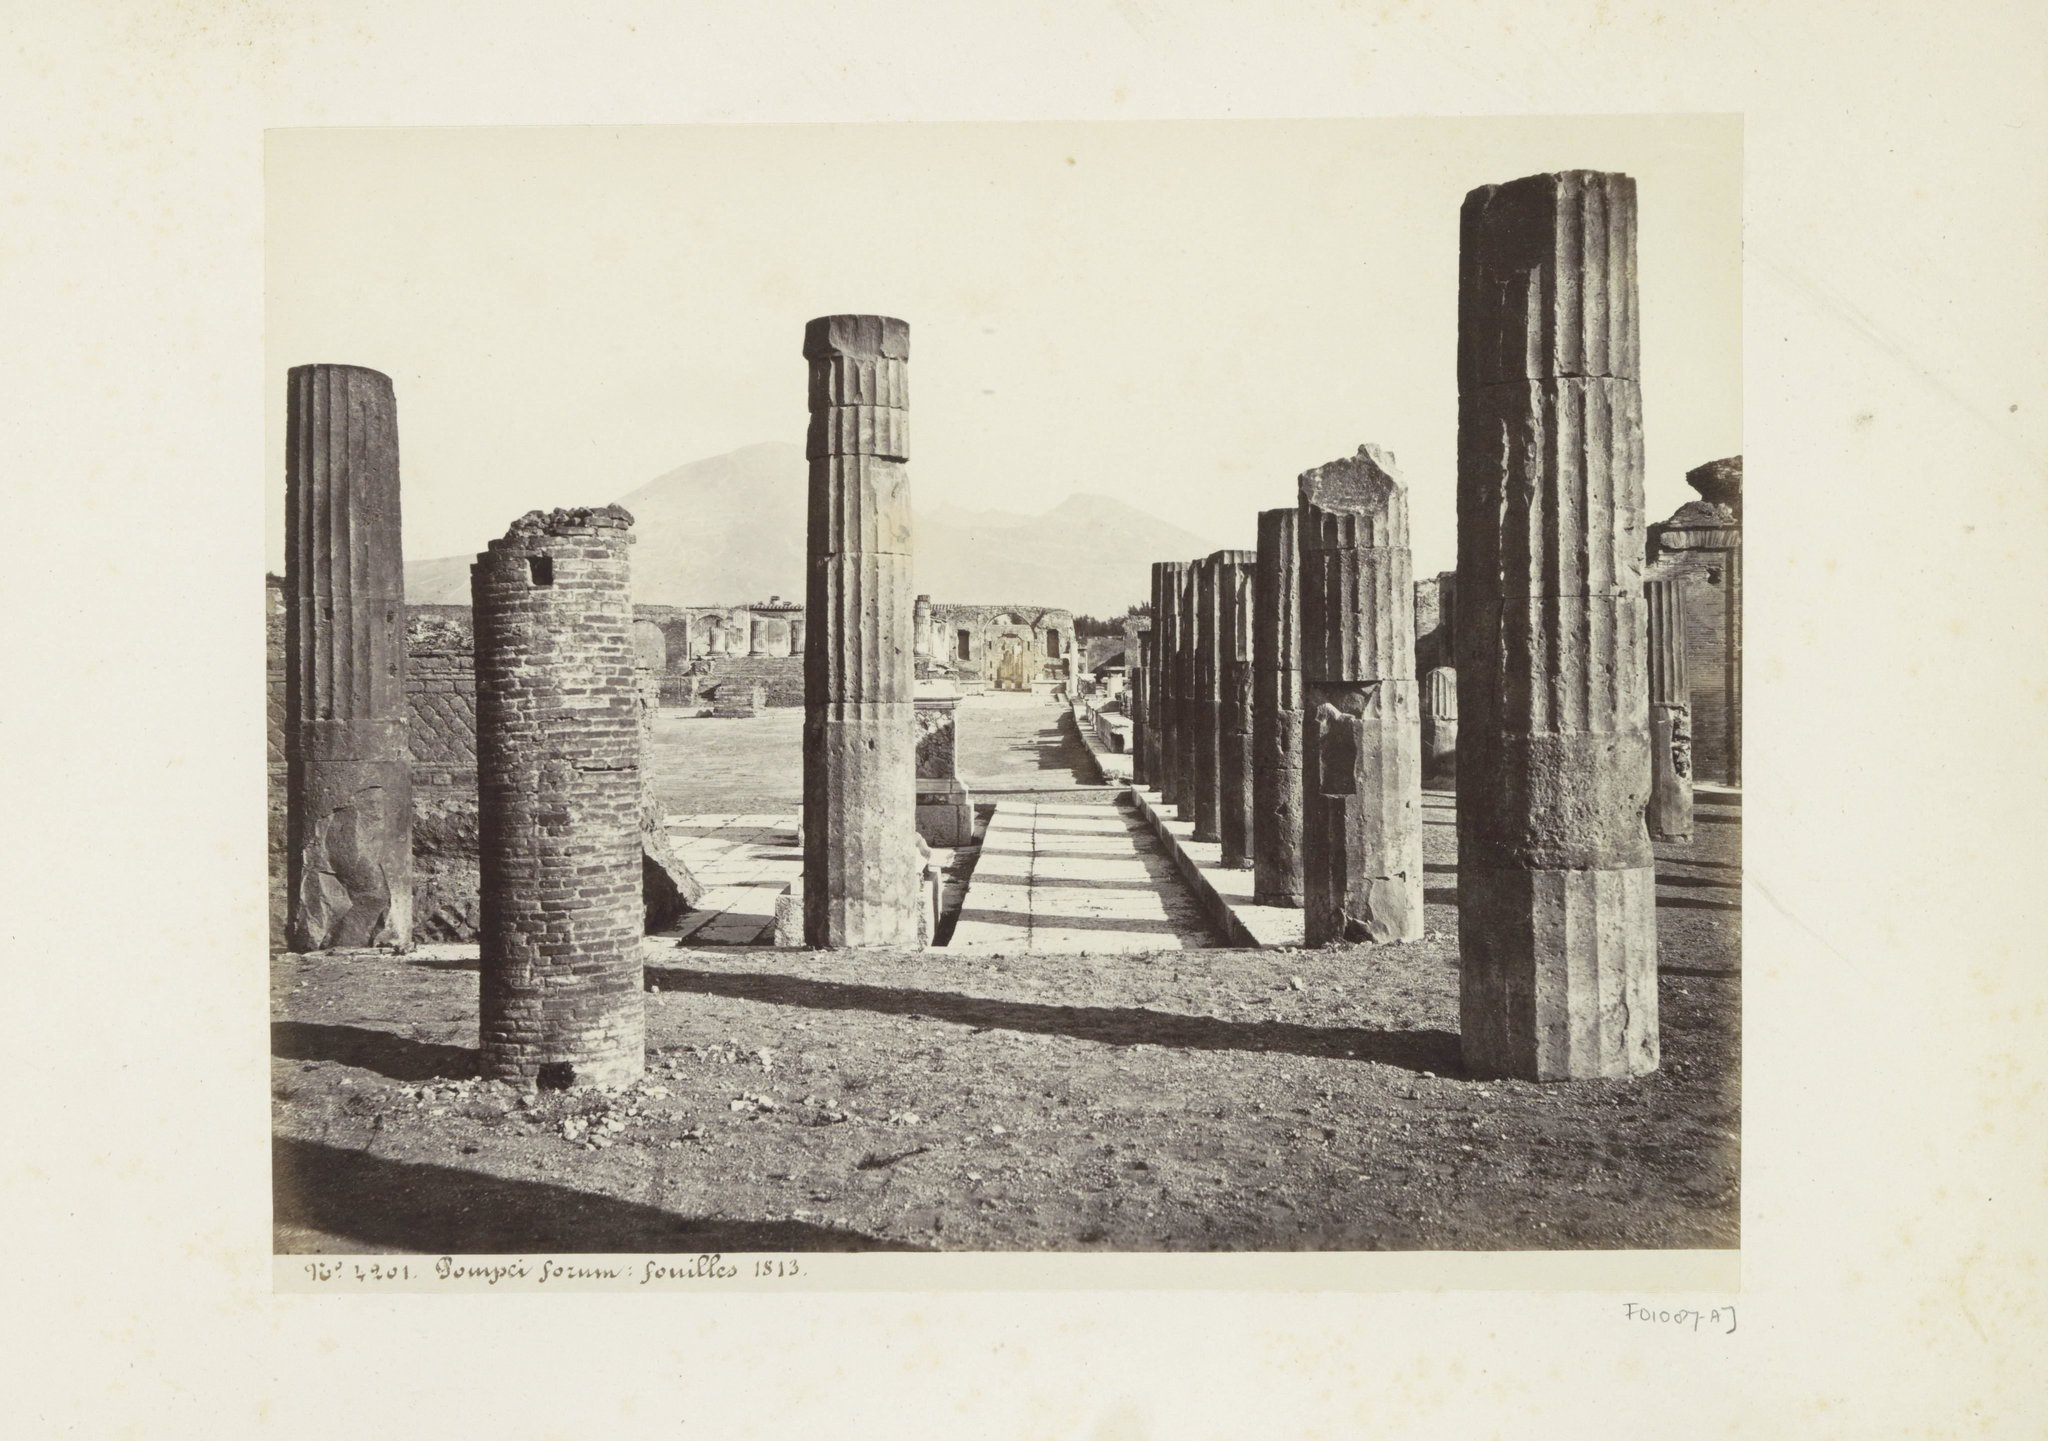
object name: photograph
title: Pompei forum: fouilles 1813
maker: Anonymous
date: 1865-1875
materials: paper, photographic support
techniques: albumen print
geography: pompeii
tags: column, pillar ~ architecture, excavation ~ archaeology, pompeii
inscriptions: negative number: ‘4201’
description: Onderdeel van Reisalbum met foto's van bezienswaardigheden in Napels en omgeving.